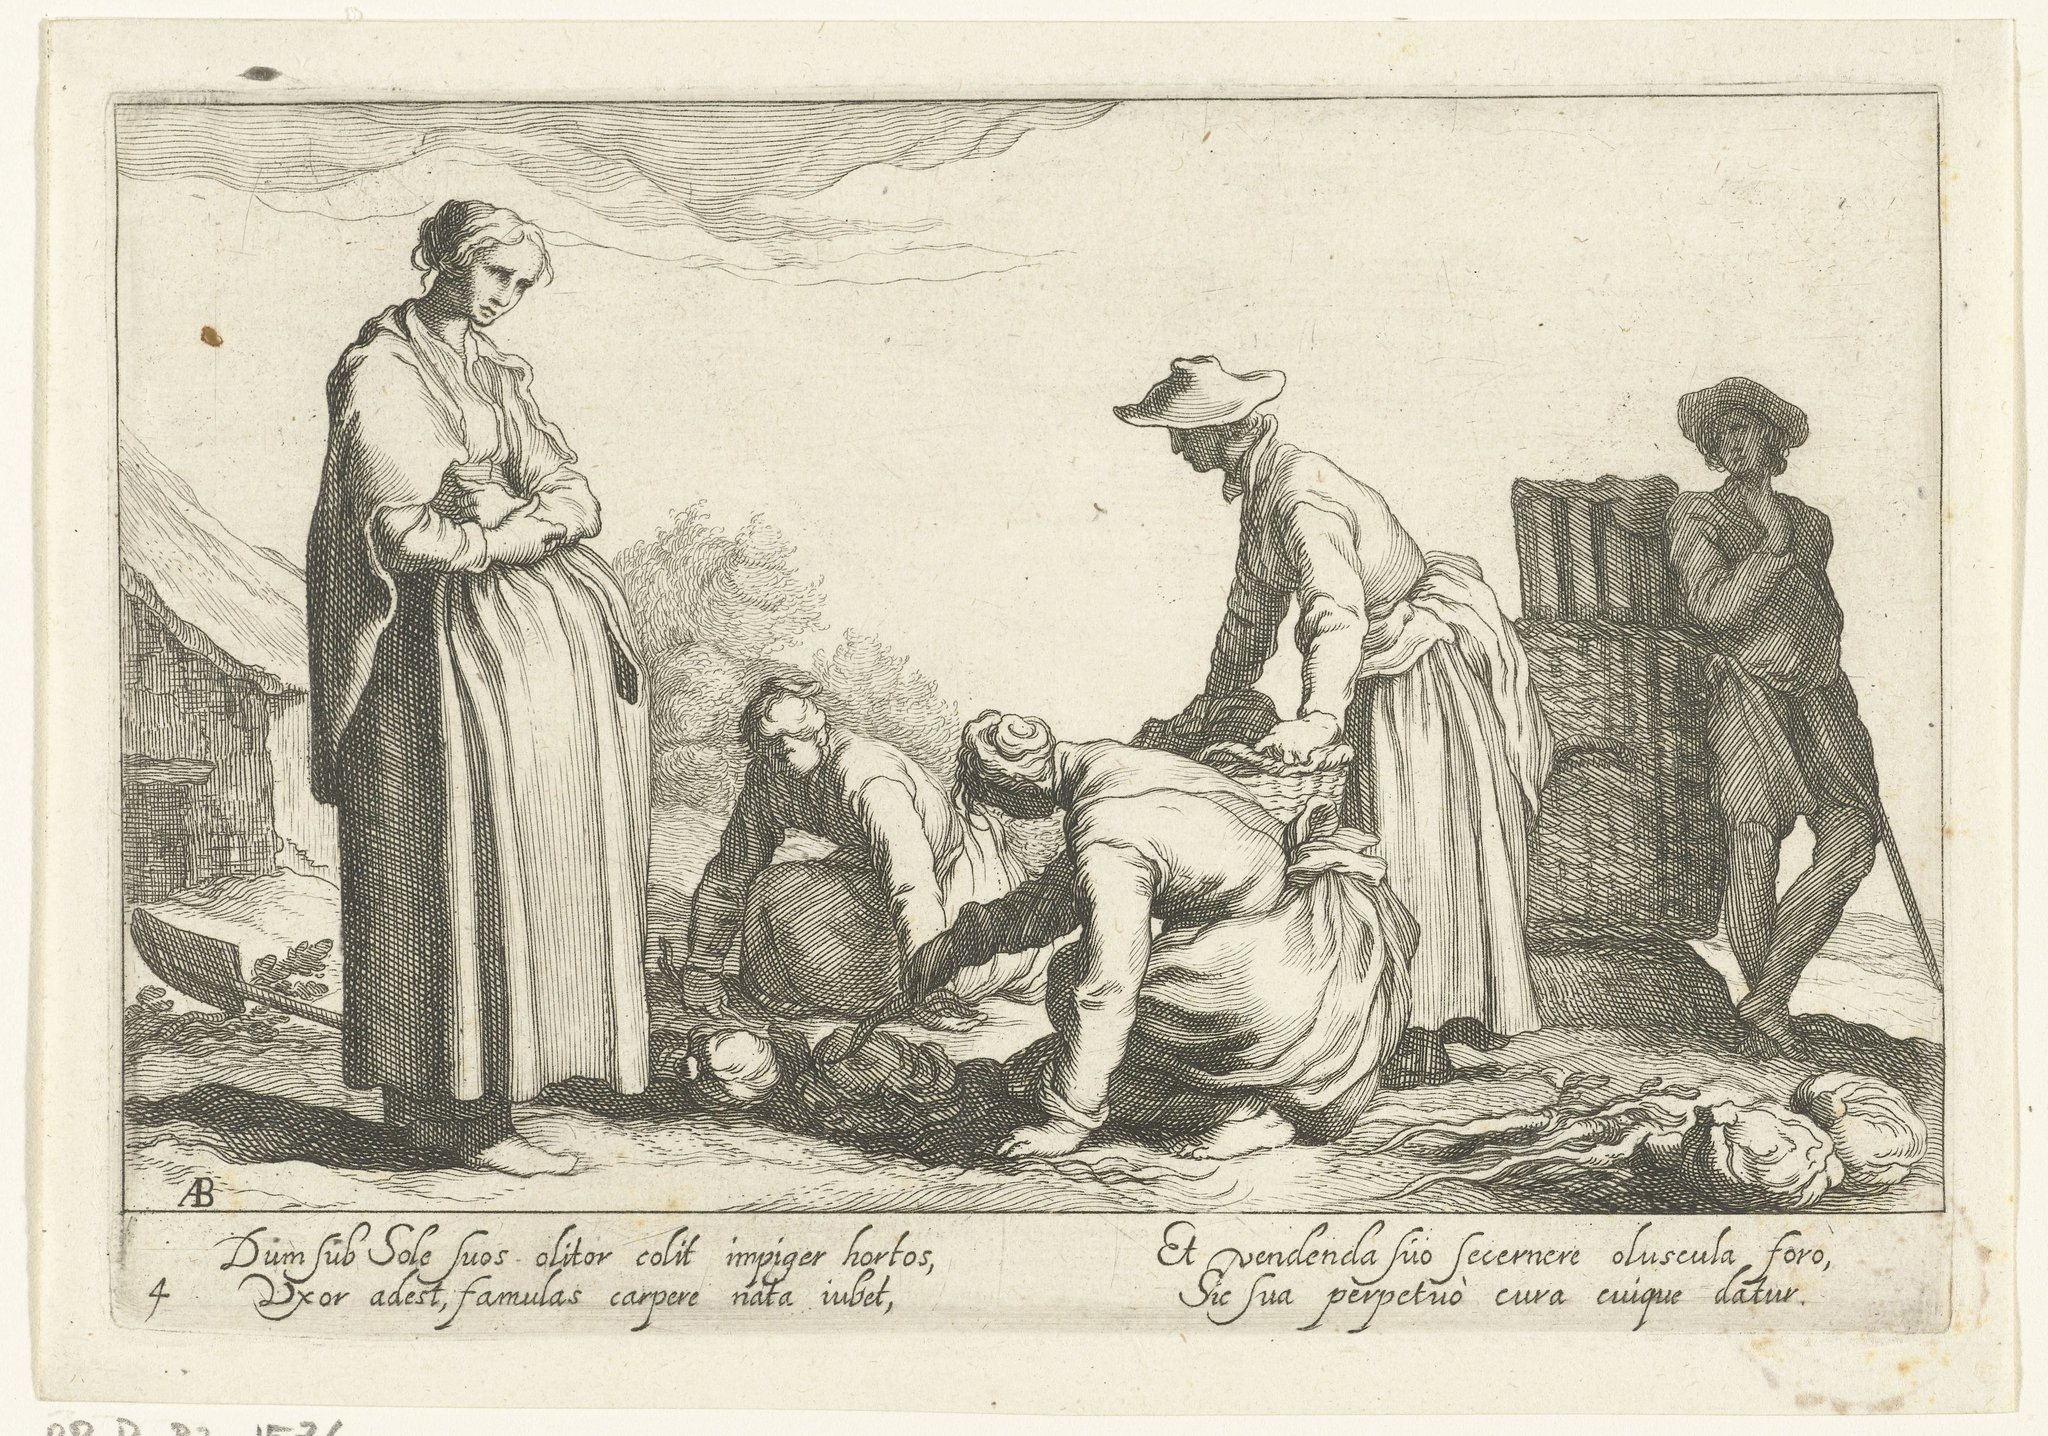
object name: print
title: Moestuin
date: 1632-1670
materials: paper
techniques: engraving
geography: utrecht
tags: horticulture, vegetable culture, market gardening, container made of plant material other than wood: basket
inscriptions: collector's mark: Lugt 240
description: Dienstmeisjes zijn aan het werk in een moestuin. Zij oogsten wortels en kolen. Links kijkt een staande vrouw toe.